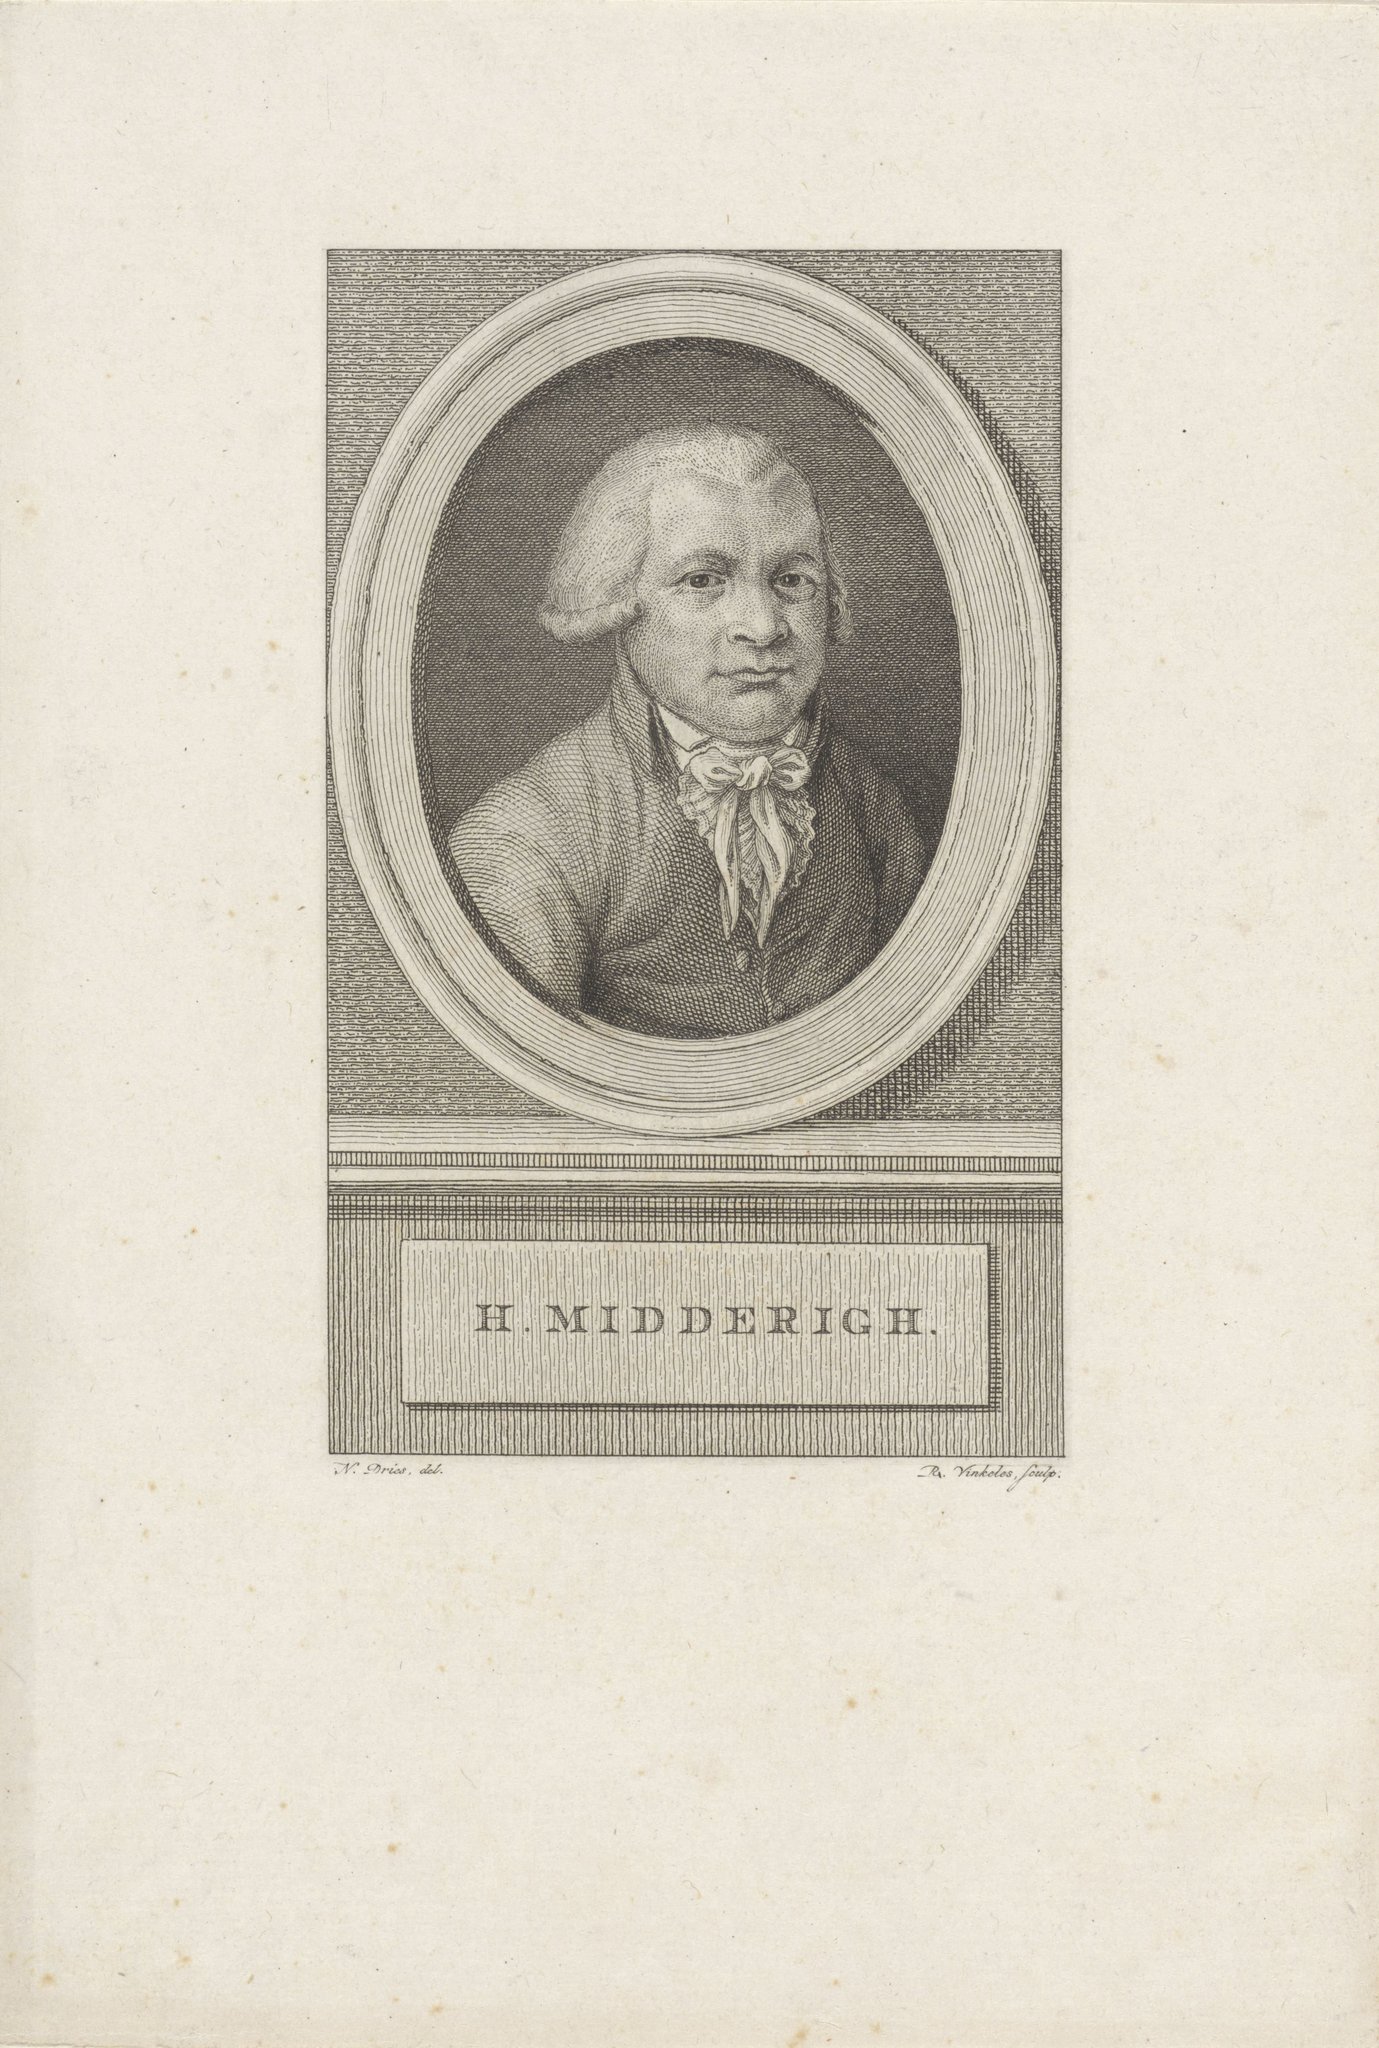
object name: print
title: Portret van Johannes Henricus Midderigh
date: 1786-1809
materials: paper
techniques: etching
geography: amsterdam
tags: rotterdam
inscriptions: collector's mark: Lugt 2228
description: Prent ook gebruikt als boekillustratie in: Wagenaar, Jan. Vaderlandsche historie, (...) ten vervolge van Wagenaars Vaderlandsche historie. Dl. 1-43. Amsterdam: Johannes Allart, 1786-1809.